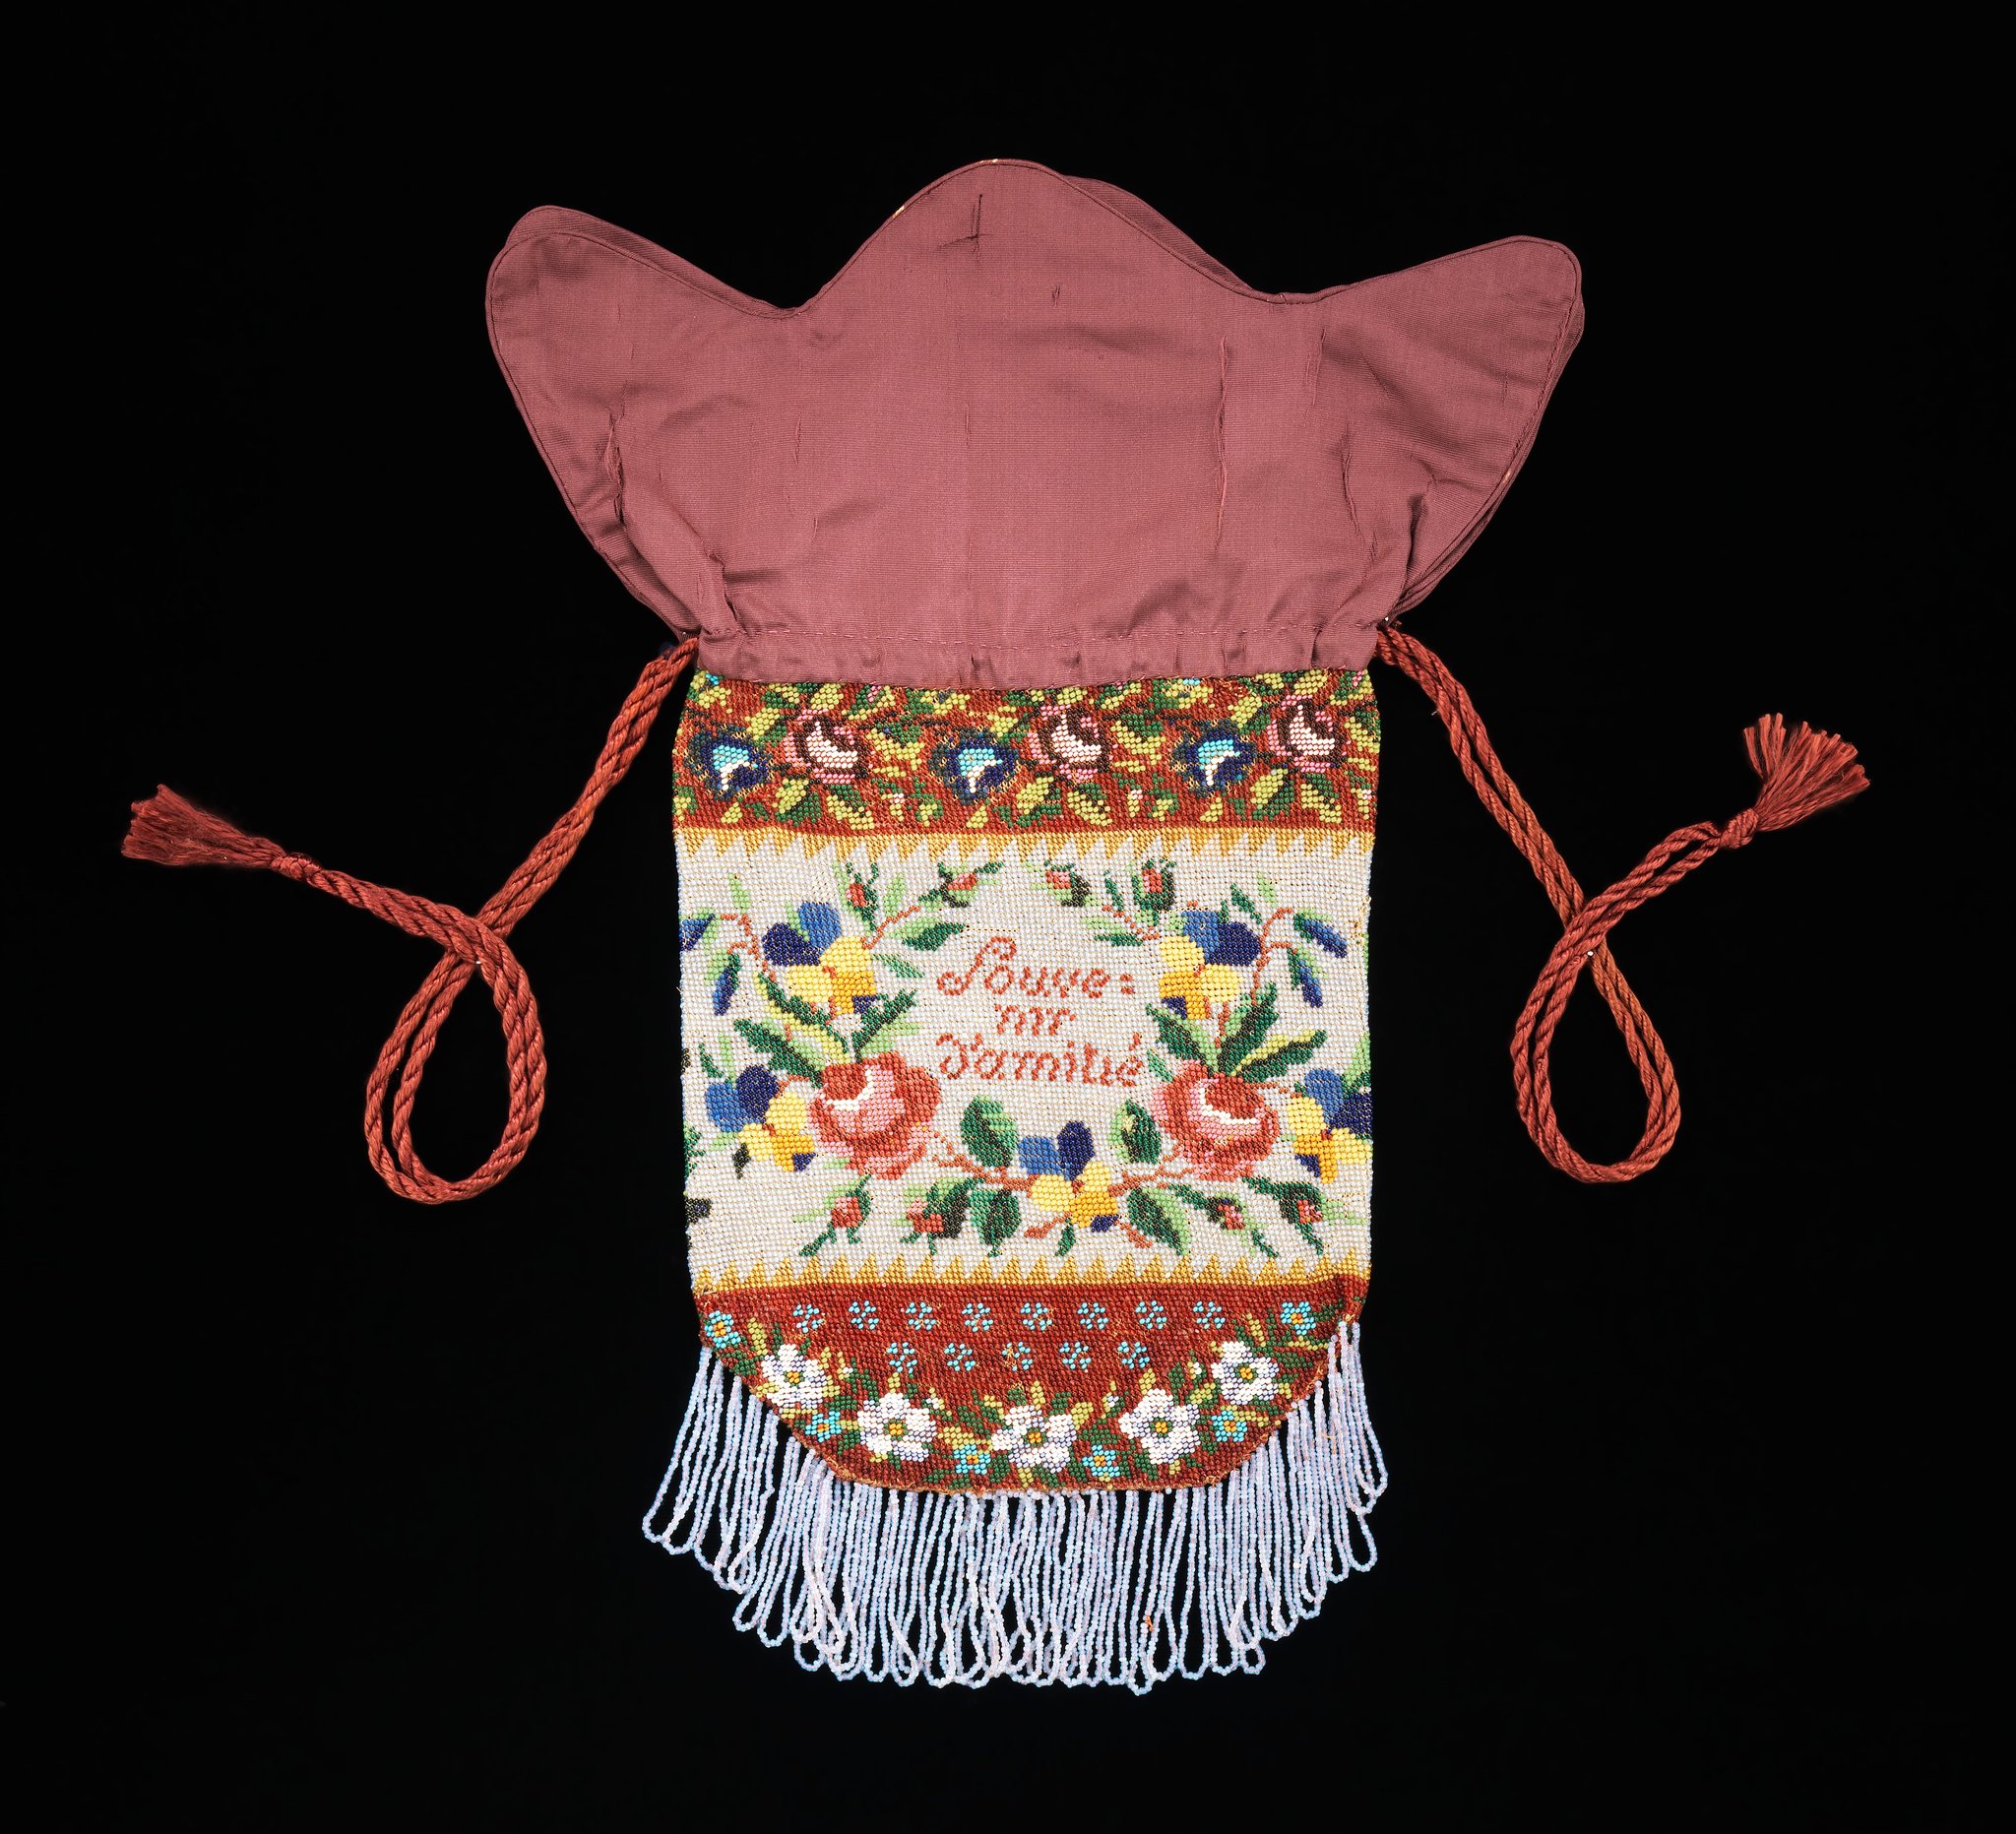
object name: pouch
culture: french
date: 1870-1879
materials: glass, linen, silk